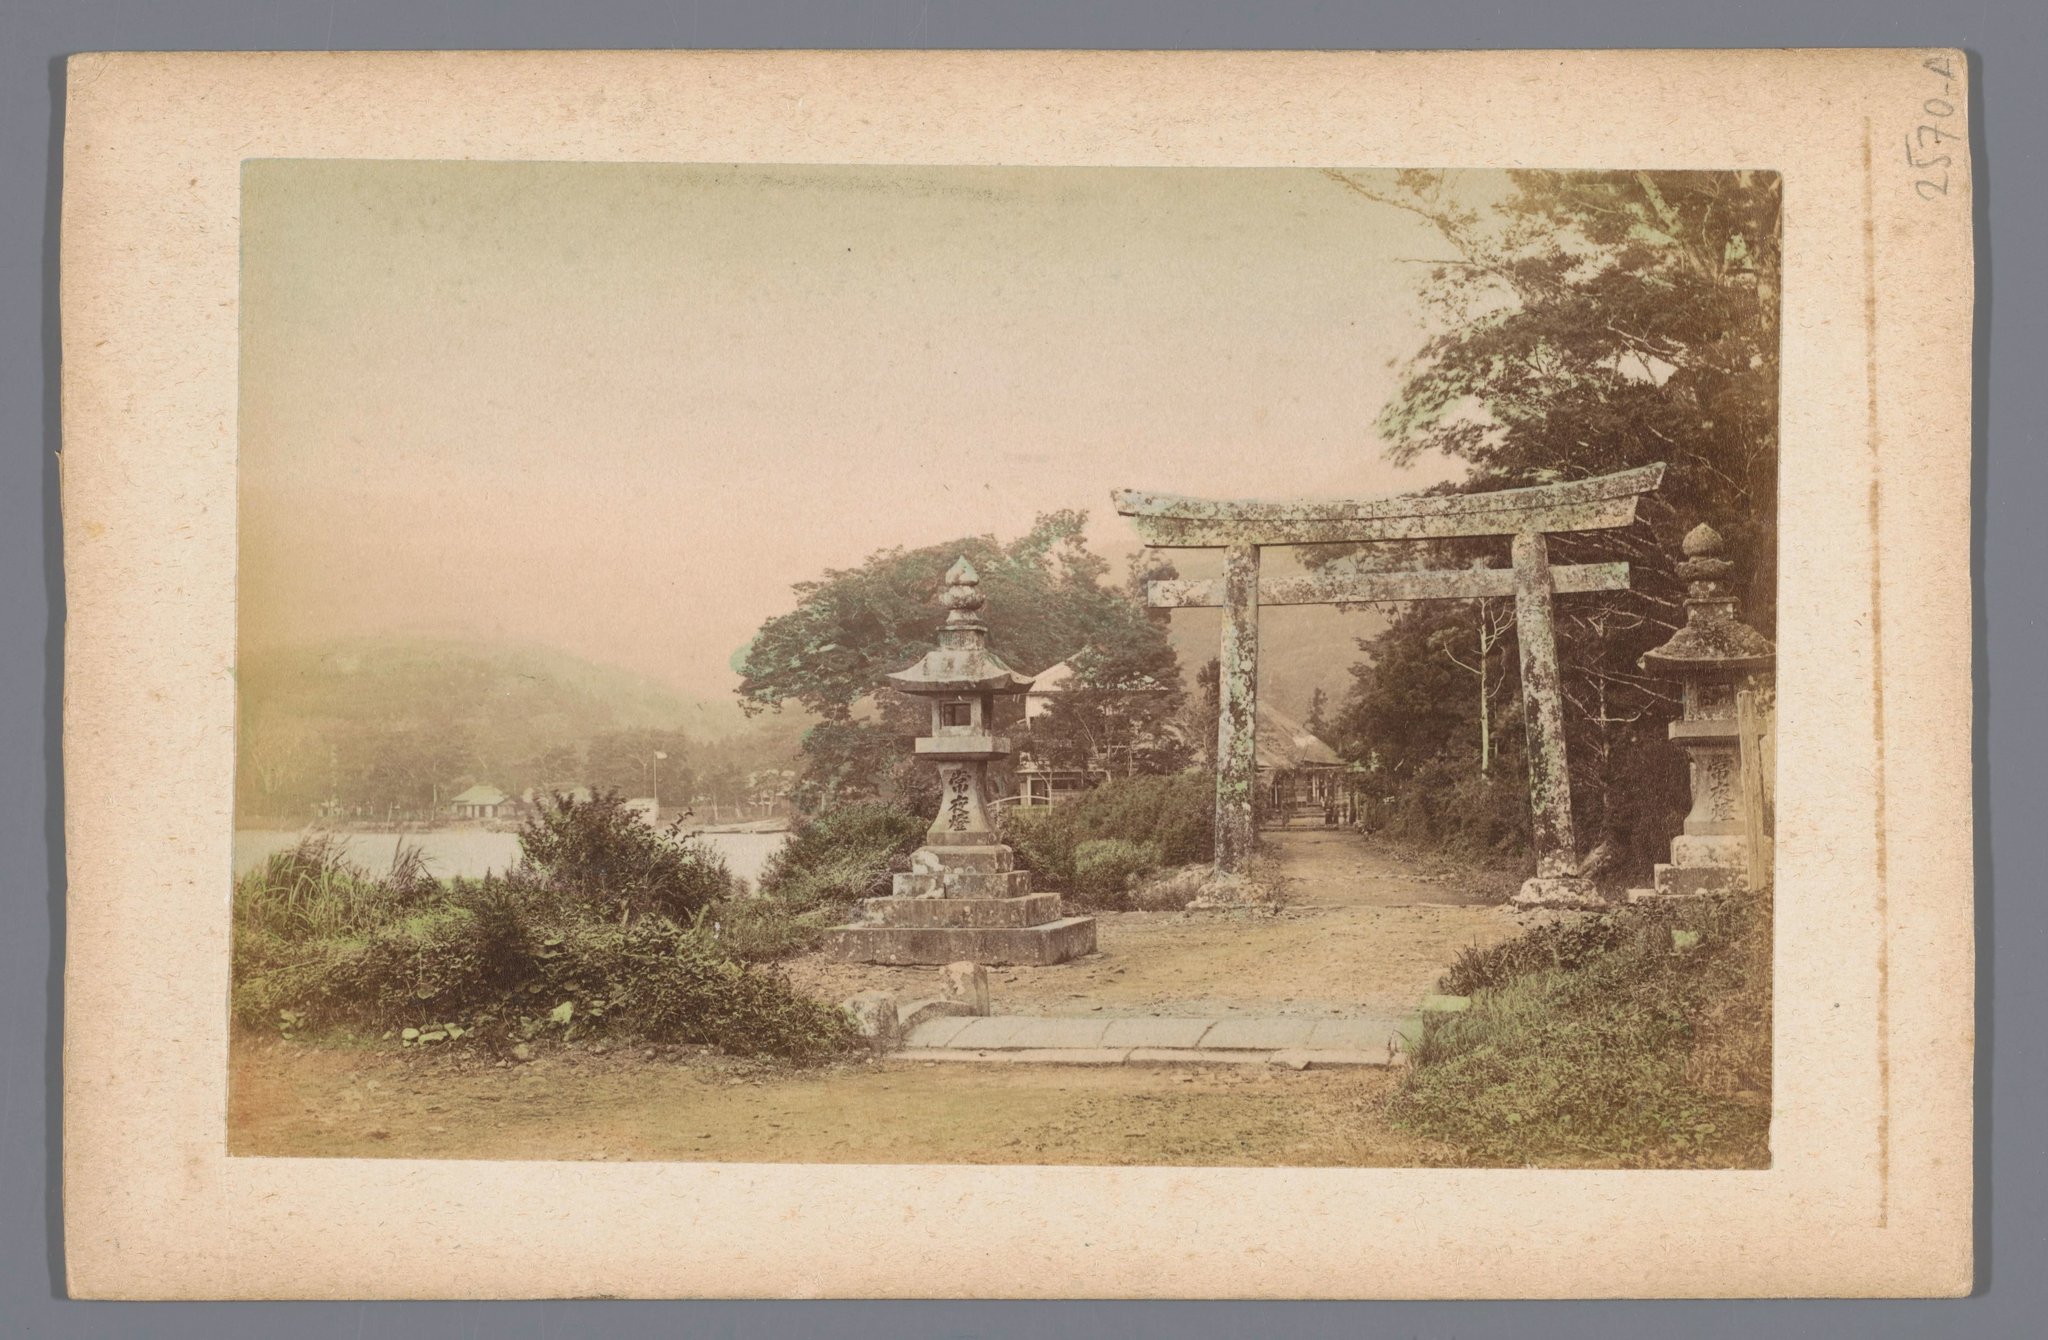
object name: photograph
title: Dorp aan een kust in Japan, op de voorgrond een Torii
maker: Anonymous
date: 1860-1900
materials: cardboard, paper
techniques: albumen print, hand coloring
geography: japan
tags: village, japan